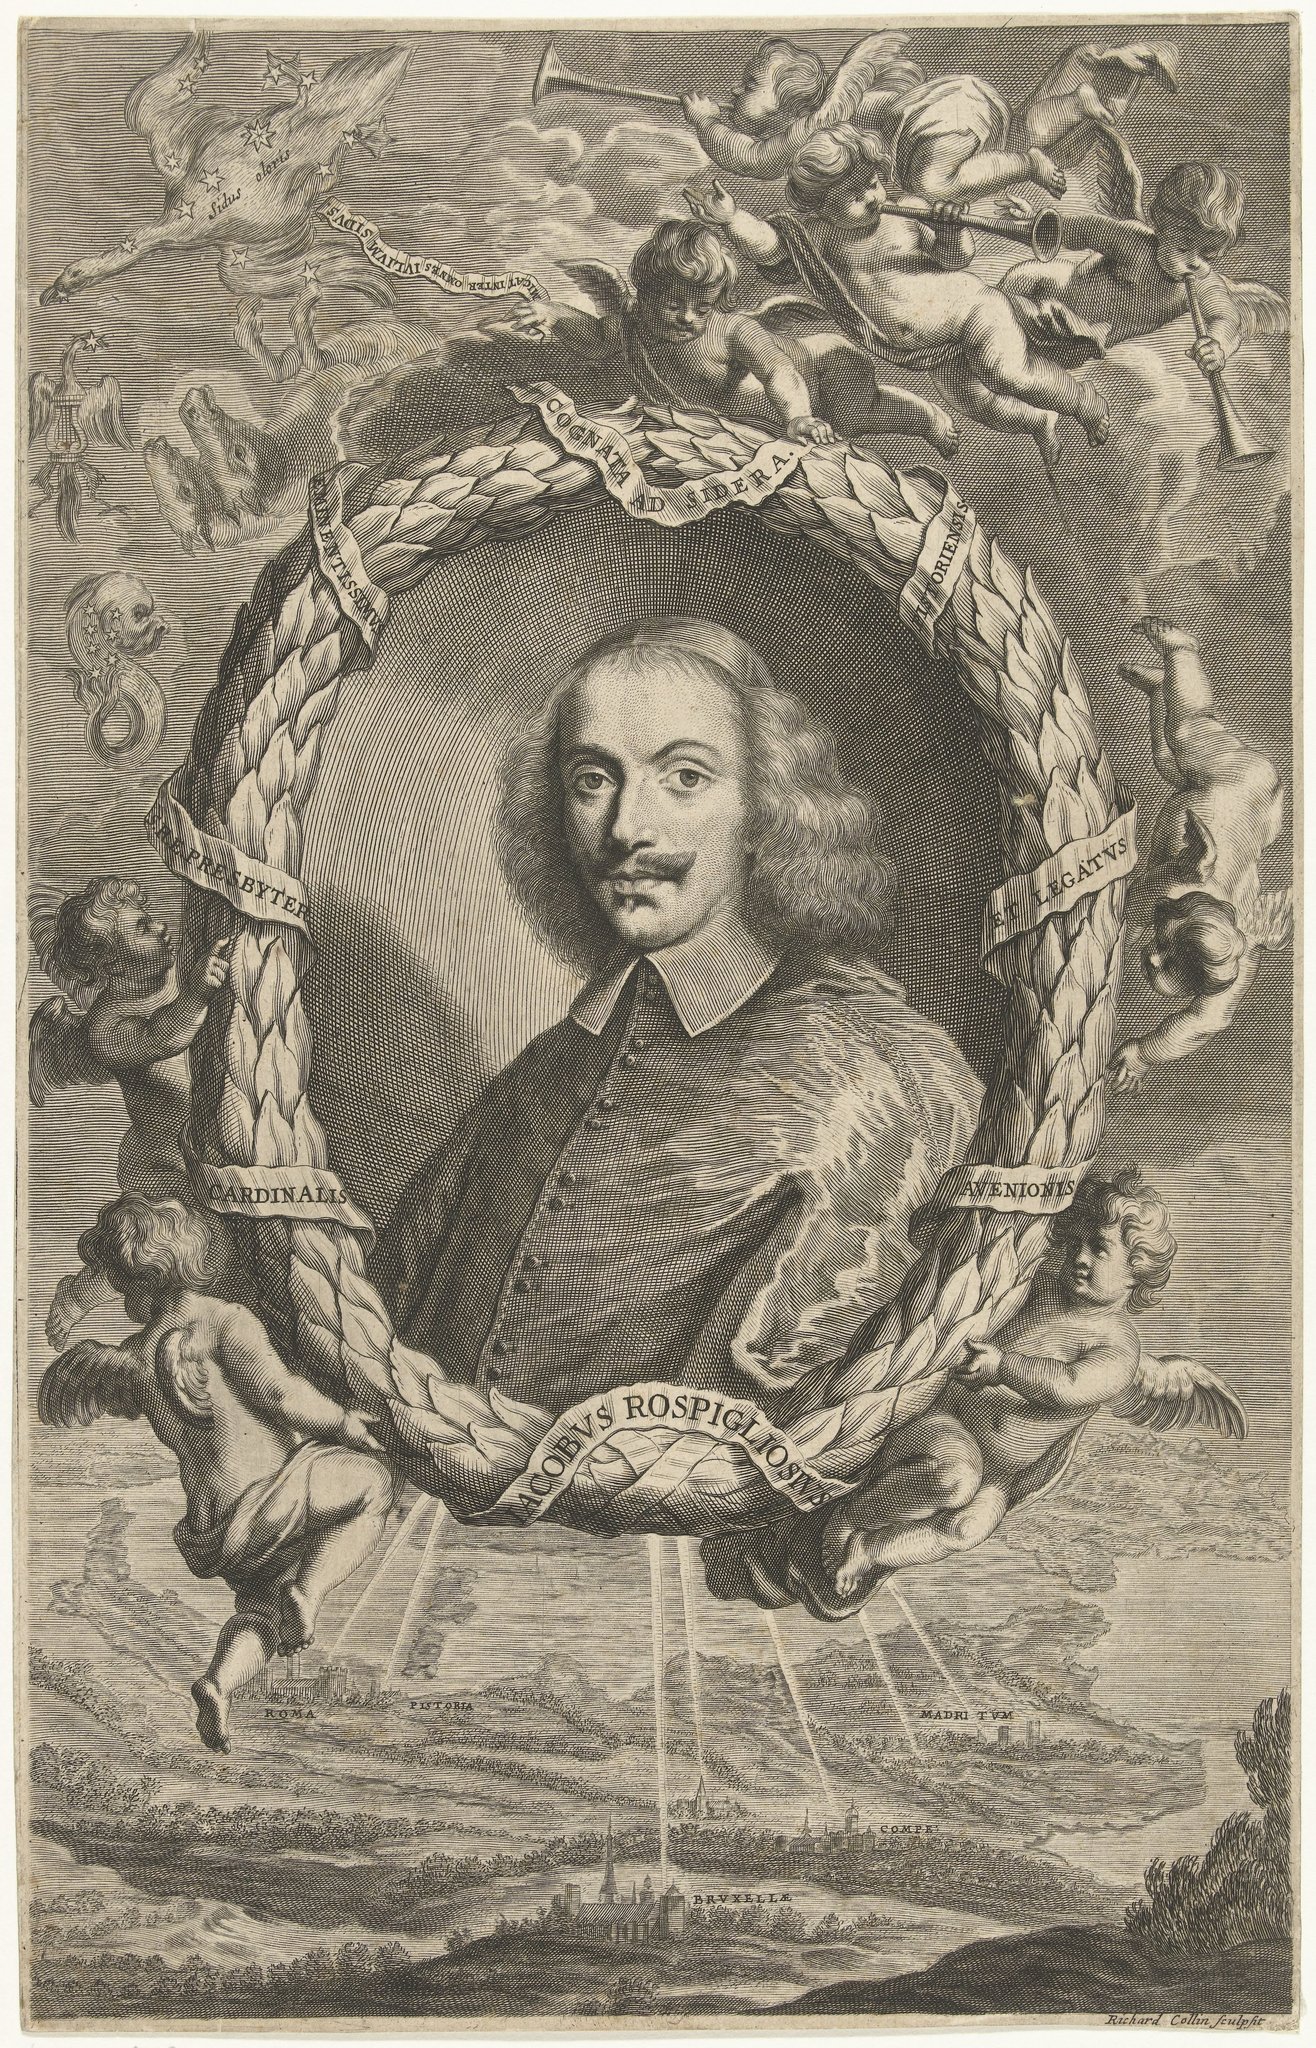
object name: print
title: Portret van kardinaal Giacomo Rospigliosi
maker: richard collin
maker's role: print maker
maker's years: 1627-1697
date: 1668-1697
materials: paper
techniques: engraving, etching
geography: antwerp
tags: kardinaal, giacomo rospigliosi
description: Borstbeeld van de kardinaal in een ovale omlijsting gedragen door engelen. Op de achtergrond een kaart met de steden die een belangrijke rol speelden in Rospigliosi's leven.